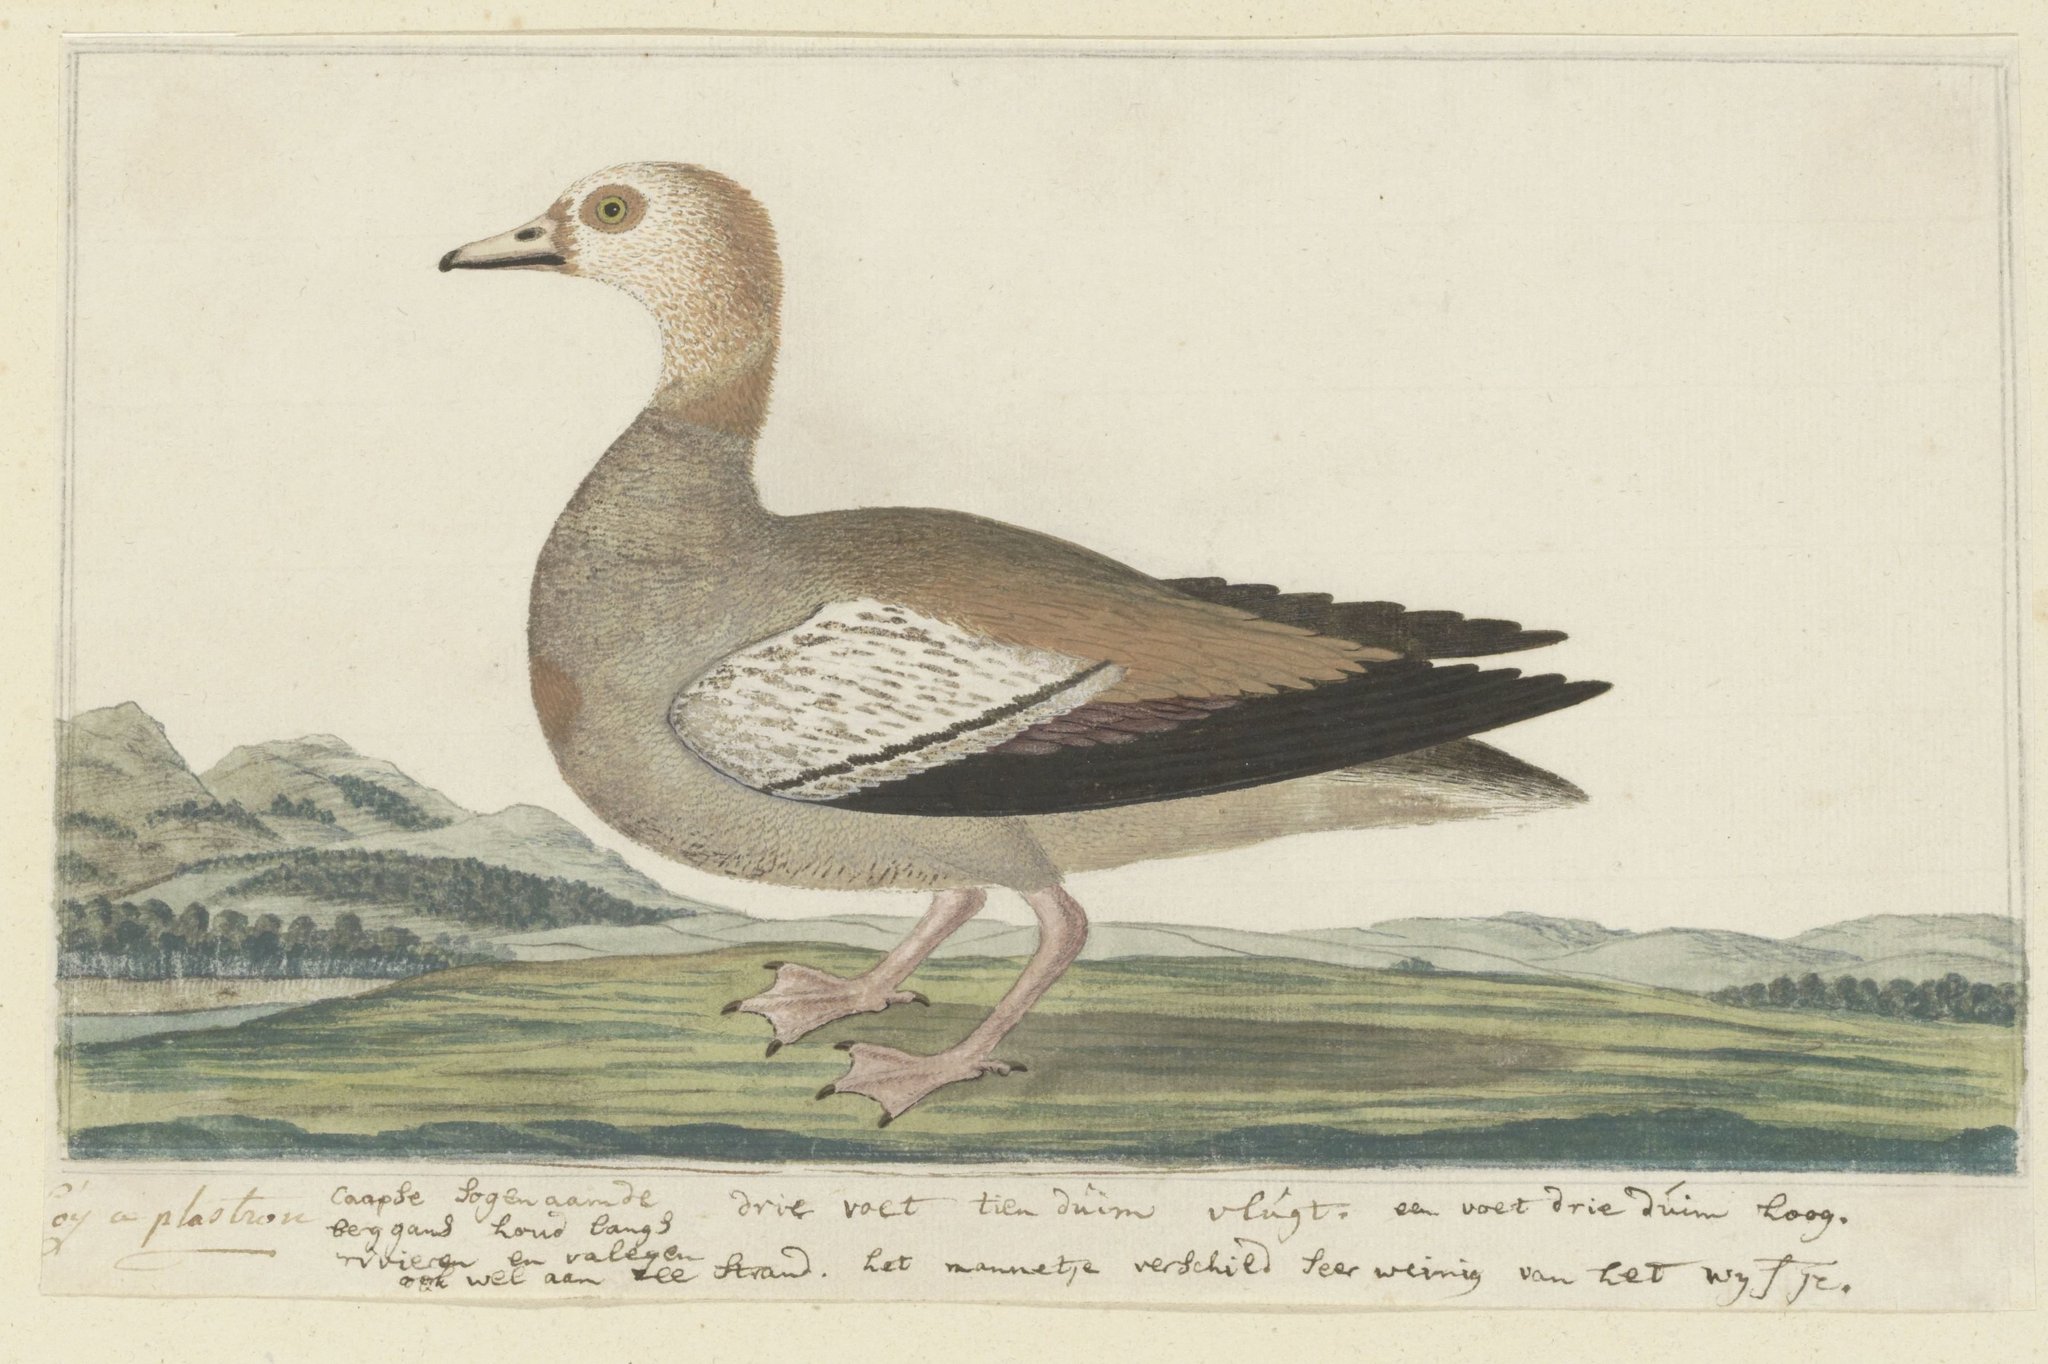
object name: album leaf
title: Alopochen aegyptiacus (Egyptian goose)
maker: robert jacob gordon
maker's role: draughtsman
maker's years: 1743-1795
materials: chalk, ink, paper, pencil, watercolor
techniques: brush, pen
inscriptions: annotation: ‘Coy a plastrou; Caapse Sogenaamde berggans/[...]; afmetingen in voet en duim’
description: Vogelstudie: Nijlgans (Alopochen aegyptiacus); identificatie als Kaapse berggans van Gordon.